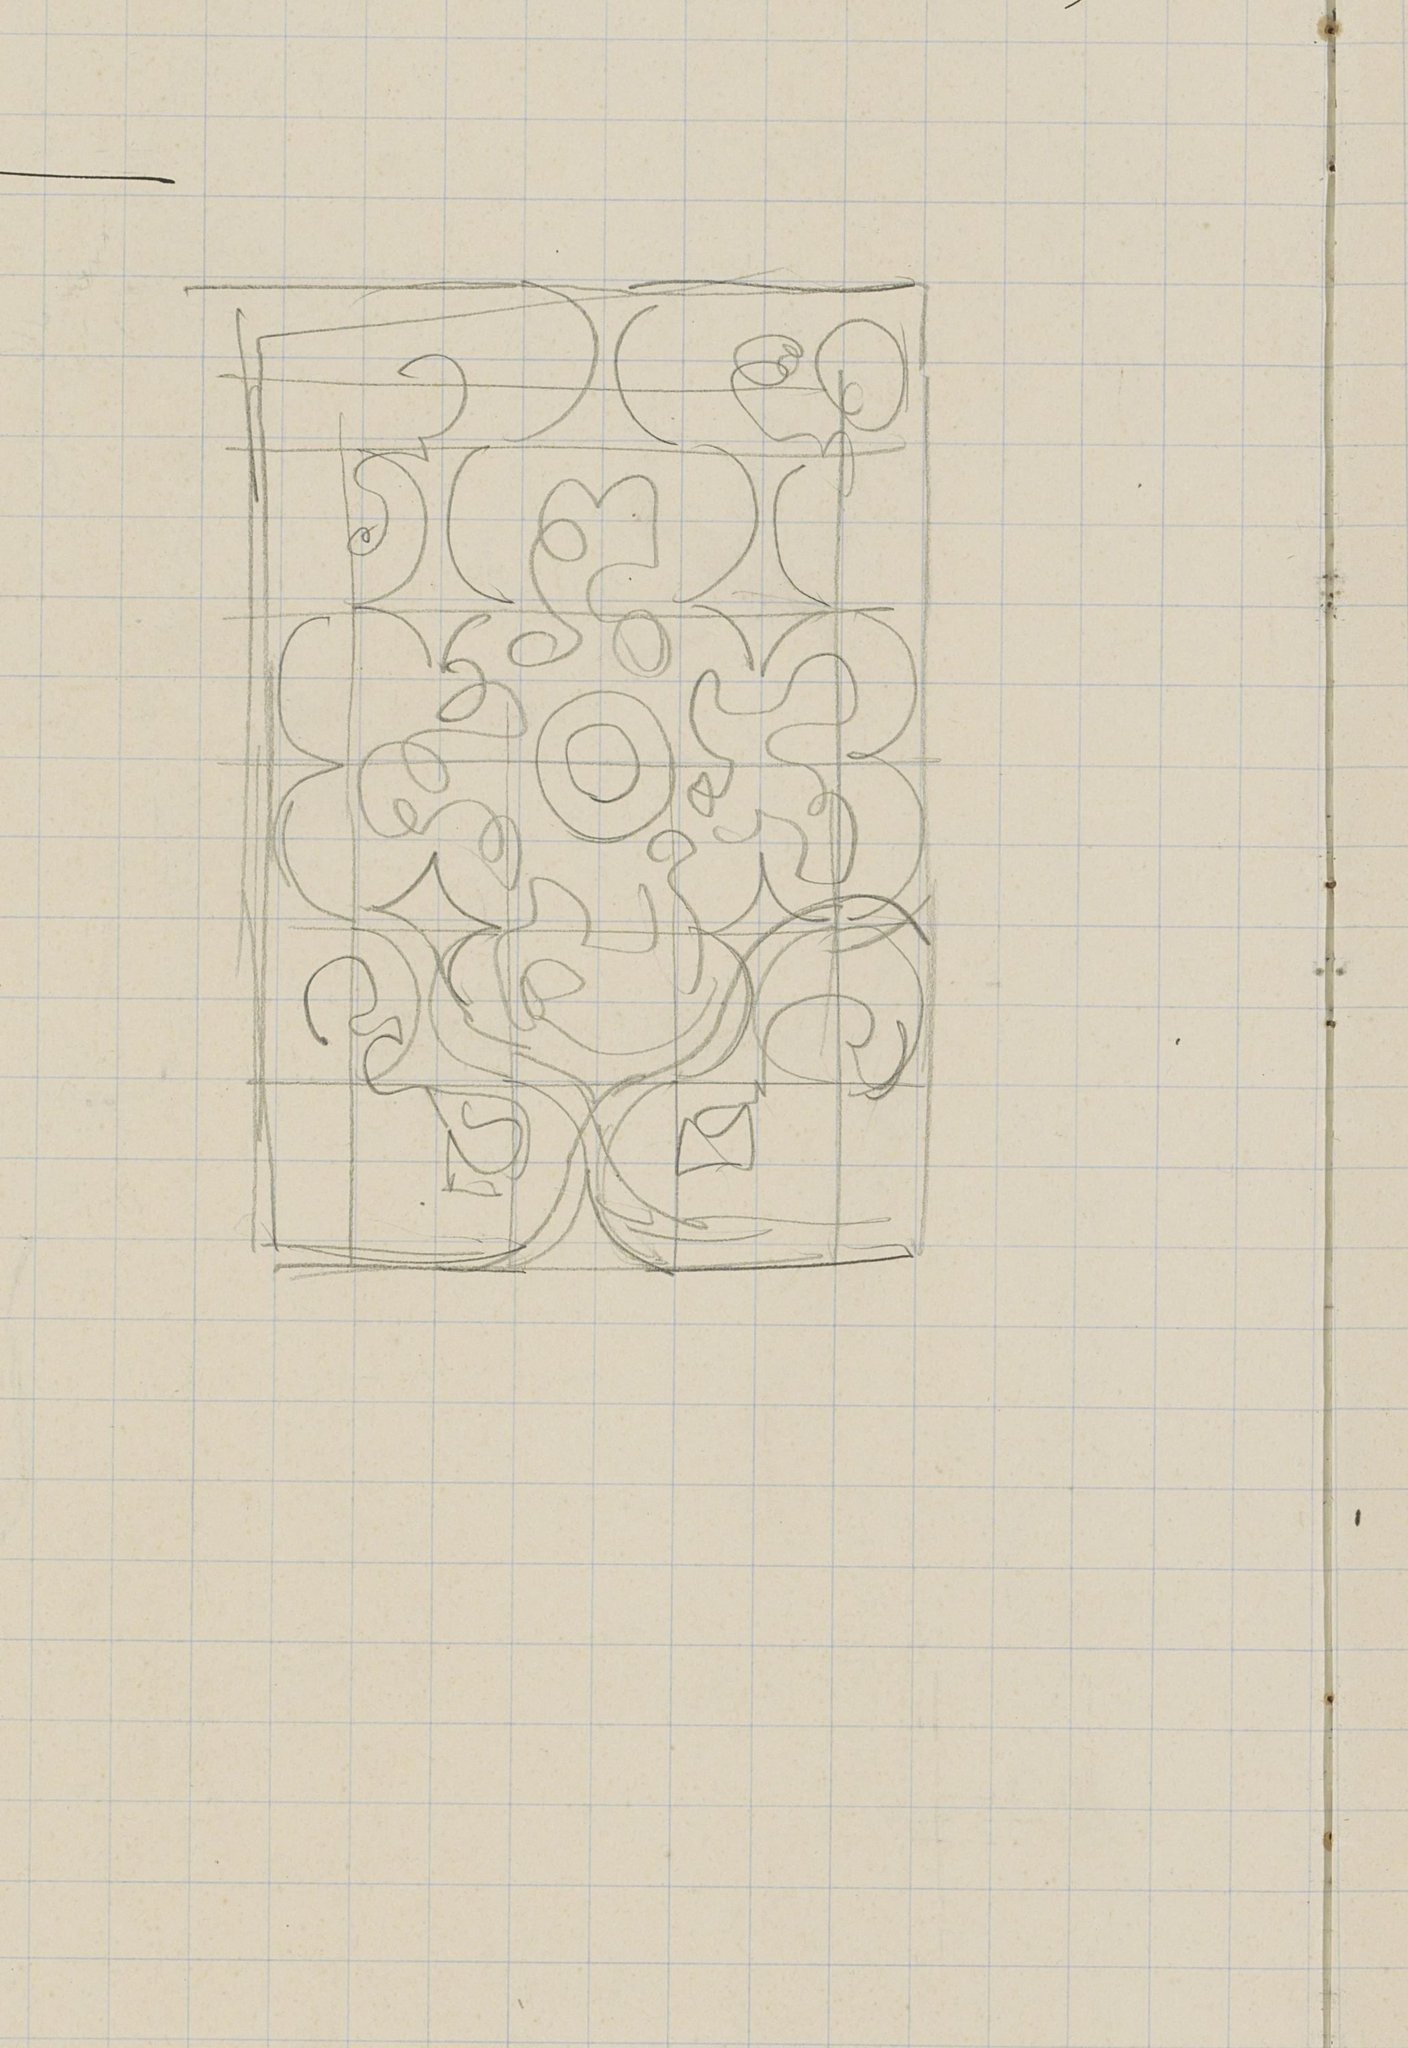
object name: sketchbook leaf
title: Ornament, lijnen en cirkels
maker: carel adolph lion cachet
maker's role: draughtsman, print maker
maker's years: 1864-1945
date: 1925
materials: ink, pencil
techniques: pen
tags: ornaments ~ art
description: Blad 3 verso uit een schetsboek met 11 bladen.